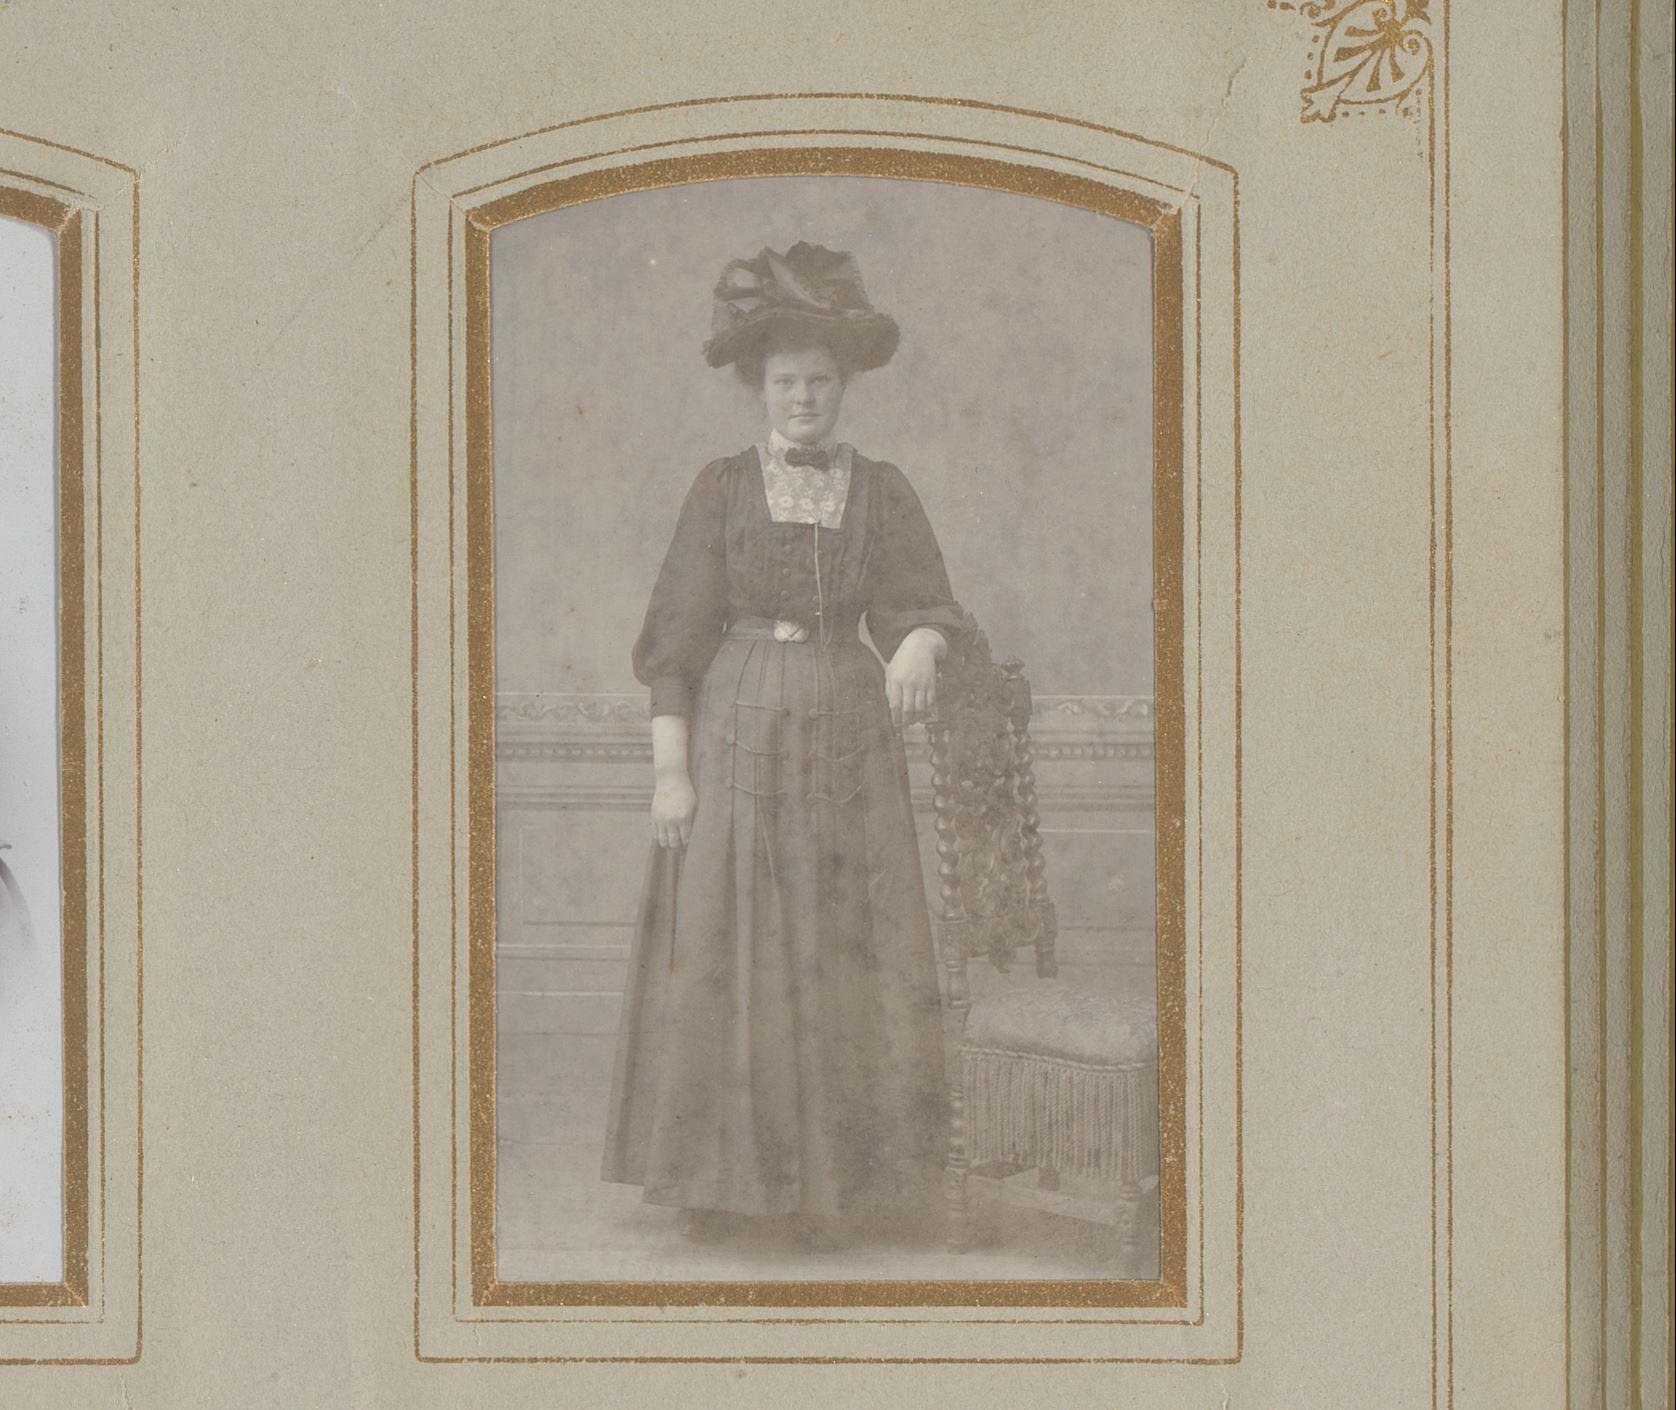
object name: photograph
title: Portret van een jonge vrouw met hoed, staand bij een stoel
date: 1895-1920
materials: cardboard, photographic support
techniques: matte daylight collodion silver print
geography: edam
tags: adolescent, young woman, maiden, historical persons - bb - woman, head-gear: hat, chair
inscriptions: inscription: ‘Atélier Siewers/ EDAM.’